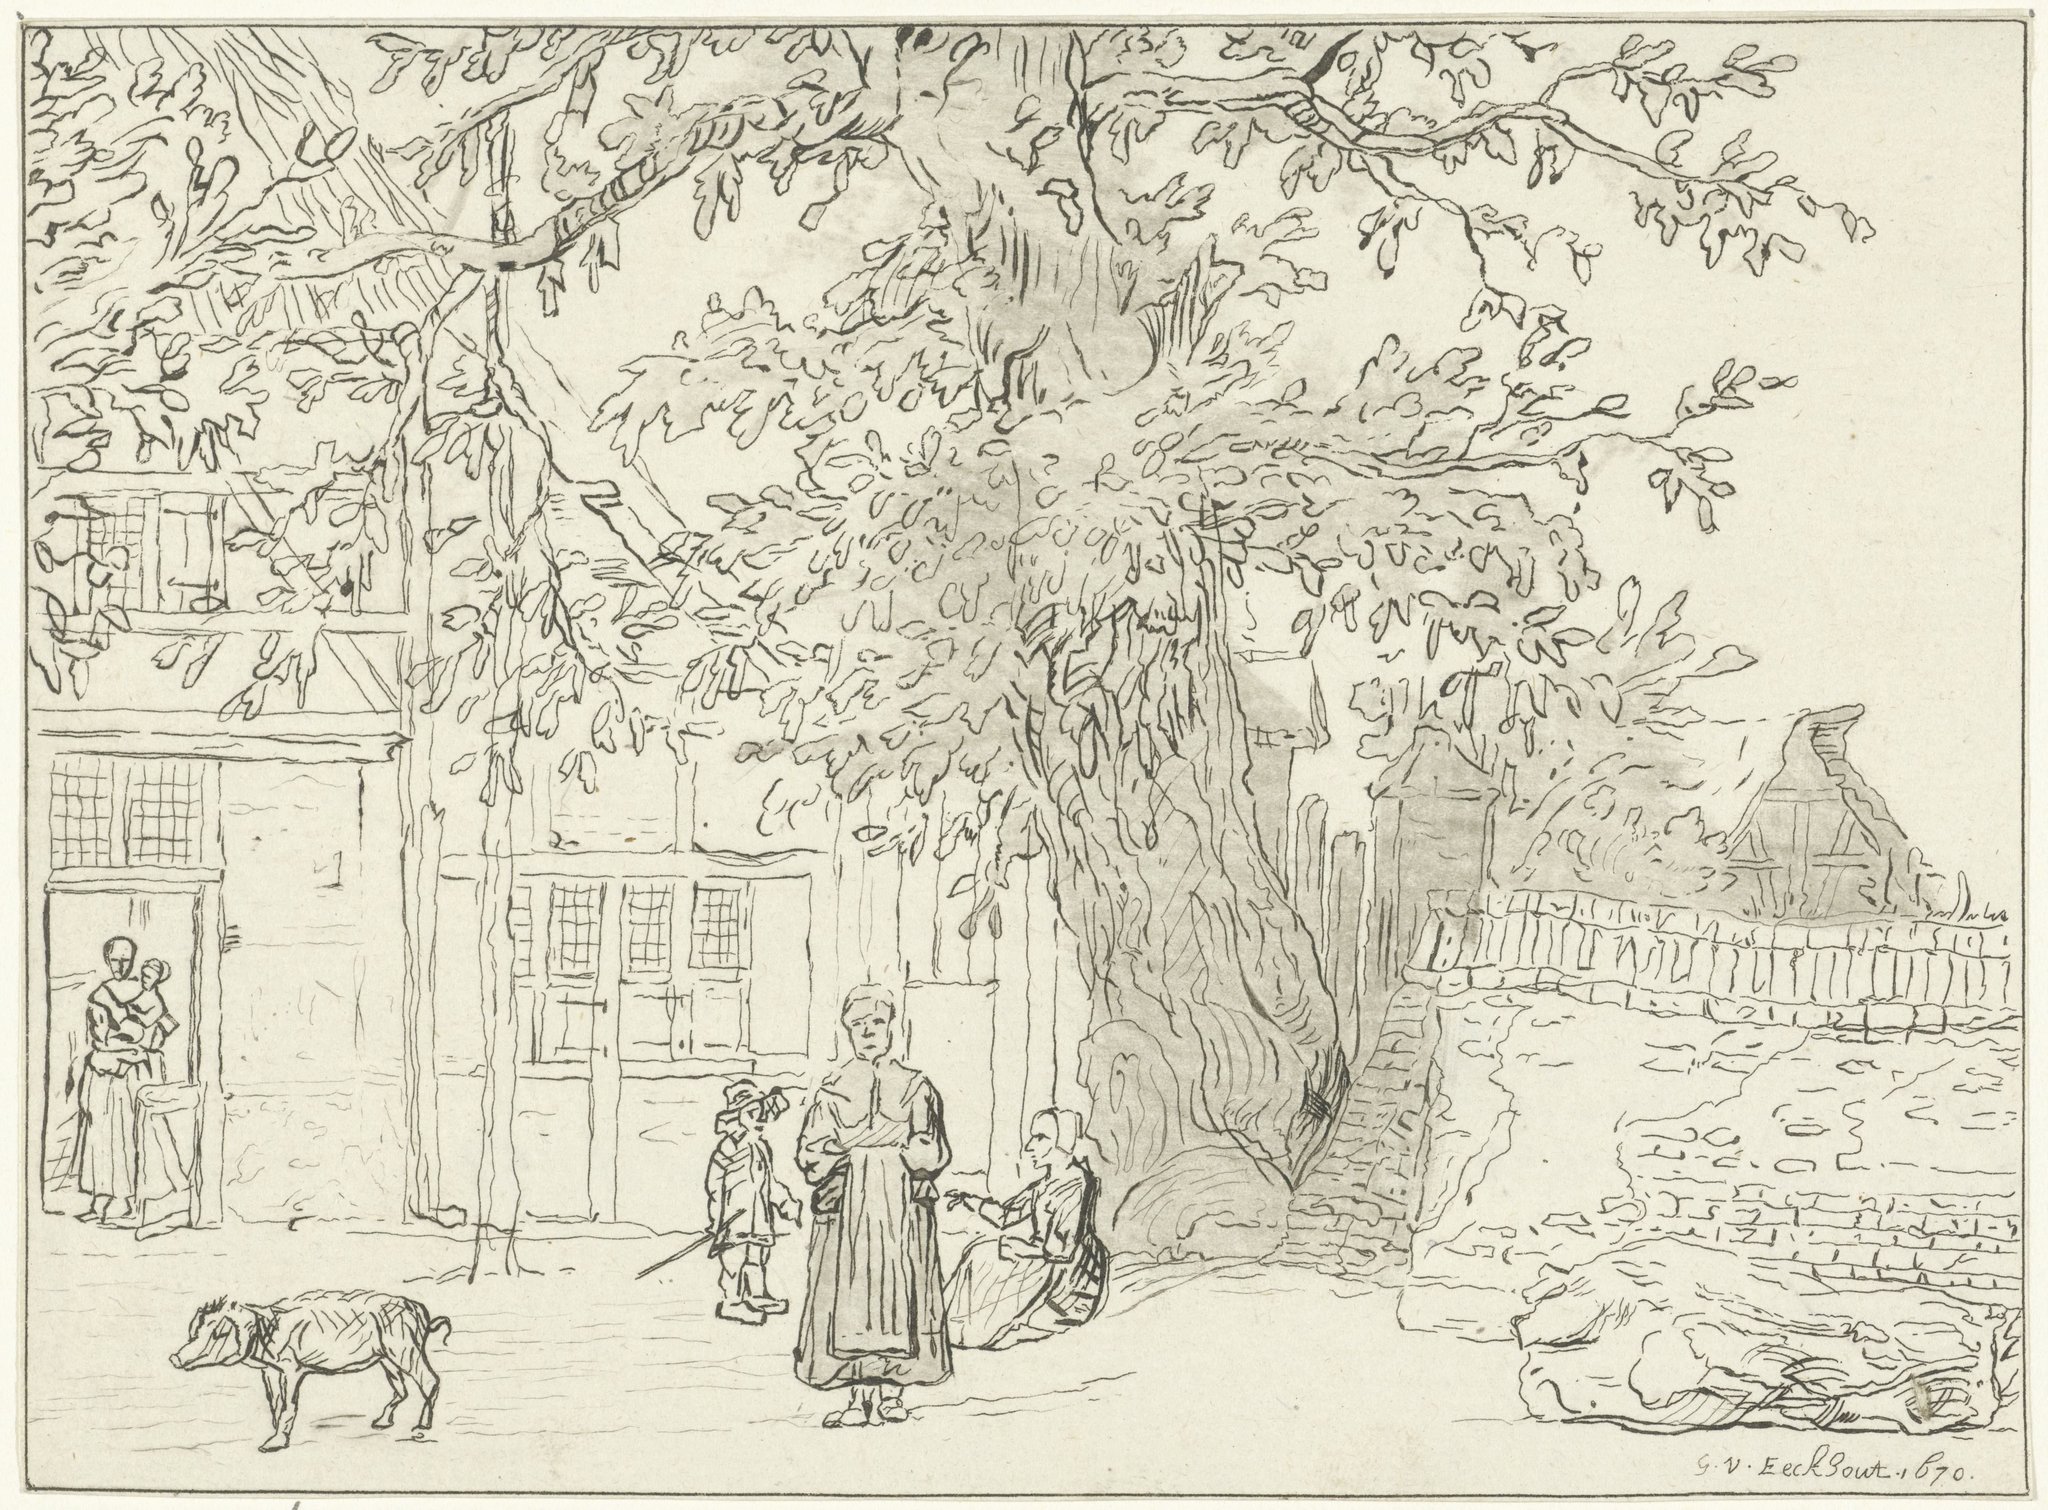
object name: print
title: Dorpsgezicht met grote boom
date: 1759-1760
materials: paper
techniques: etching, roulette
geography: amsterdam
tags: trees, pig, village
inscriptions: collector's mark: Lugt 240, inscription: ‘Geoffreerd aan mijnen waarde vriend de WEd Heer Hemsterhuis / G vd Eekhout del P. v Amstel JC. Fecit’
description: Herberg 'Zur blauen Hand am Kirchhof' te Anrath. In de deuropening een vrouw met kind op de arm. Naast de herberg een grote boom en enkele figuren daaronder. Links een varken.